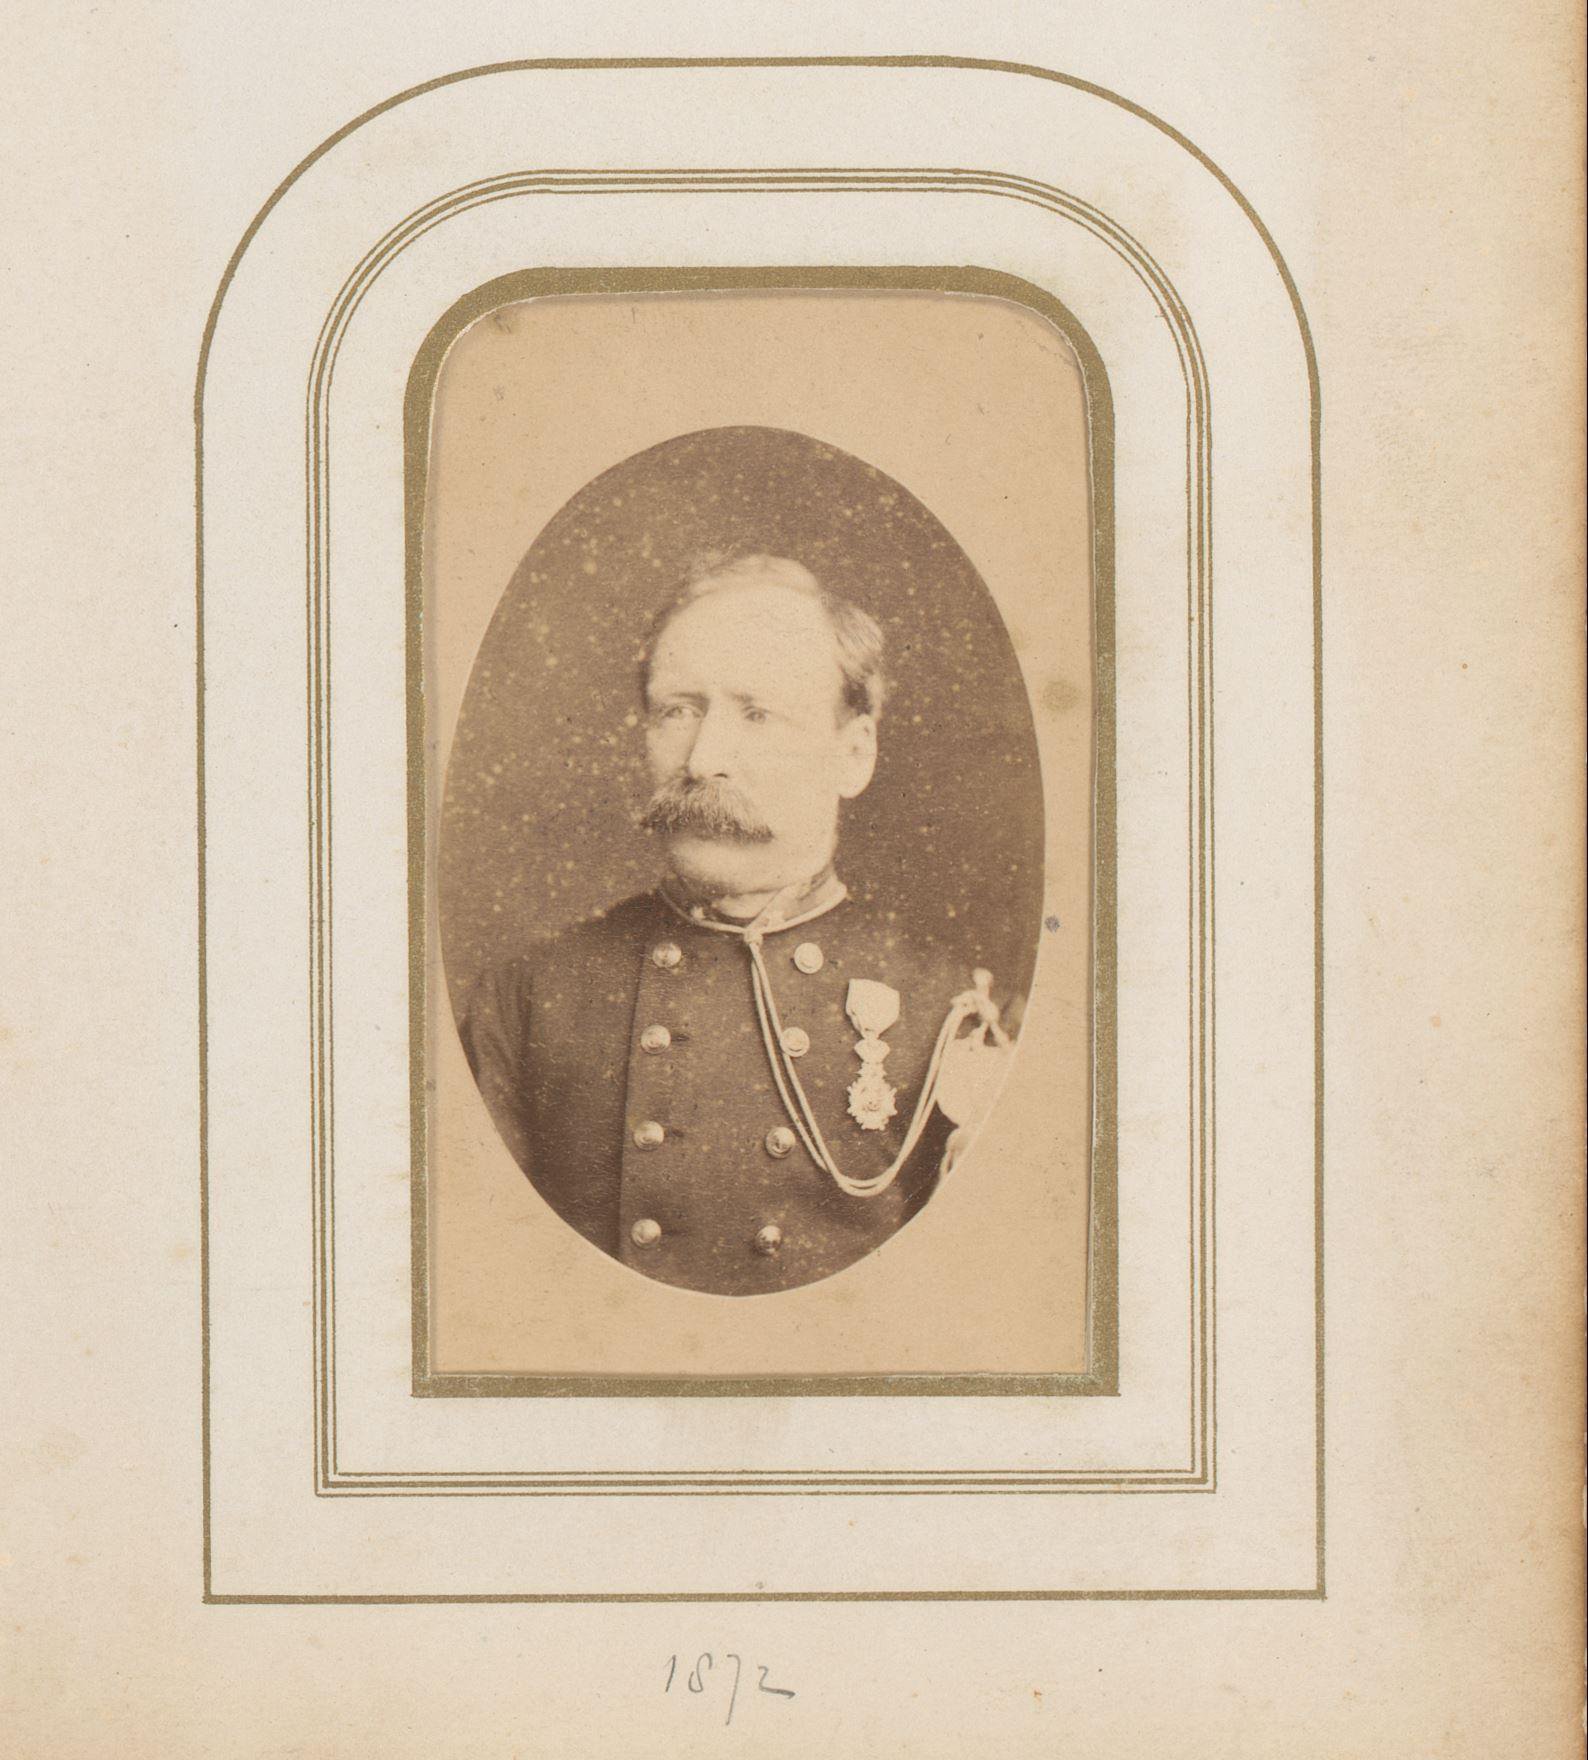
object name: album leaf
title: Portret van een man met snor in uniform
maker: f. meeus-verbeke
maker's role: fotograaf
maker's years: 1845-1906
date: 1872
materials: cardboard, photographic support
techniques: albumen print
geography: leuven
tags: moustache, historical persons, (military) uniforms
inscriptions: date: ‘1872’, inscription: ‘Photographie Inaltérable/ Procédé au Charbon/ Meeus Verbke/ 24, Rue de la Station, 24/ Louvain’, annotation: ‘affection souvenir/ a mon ami/ [...] bataille/ le Colonel Lemoine/ 1872/ [...]’